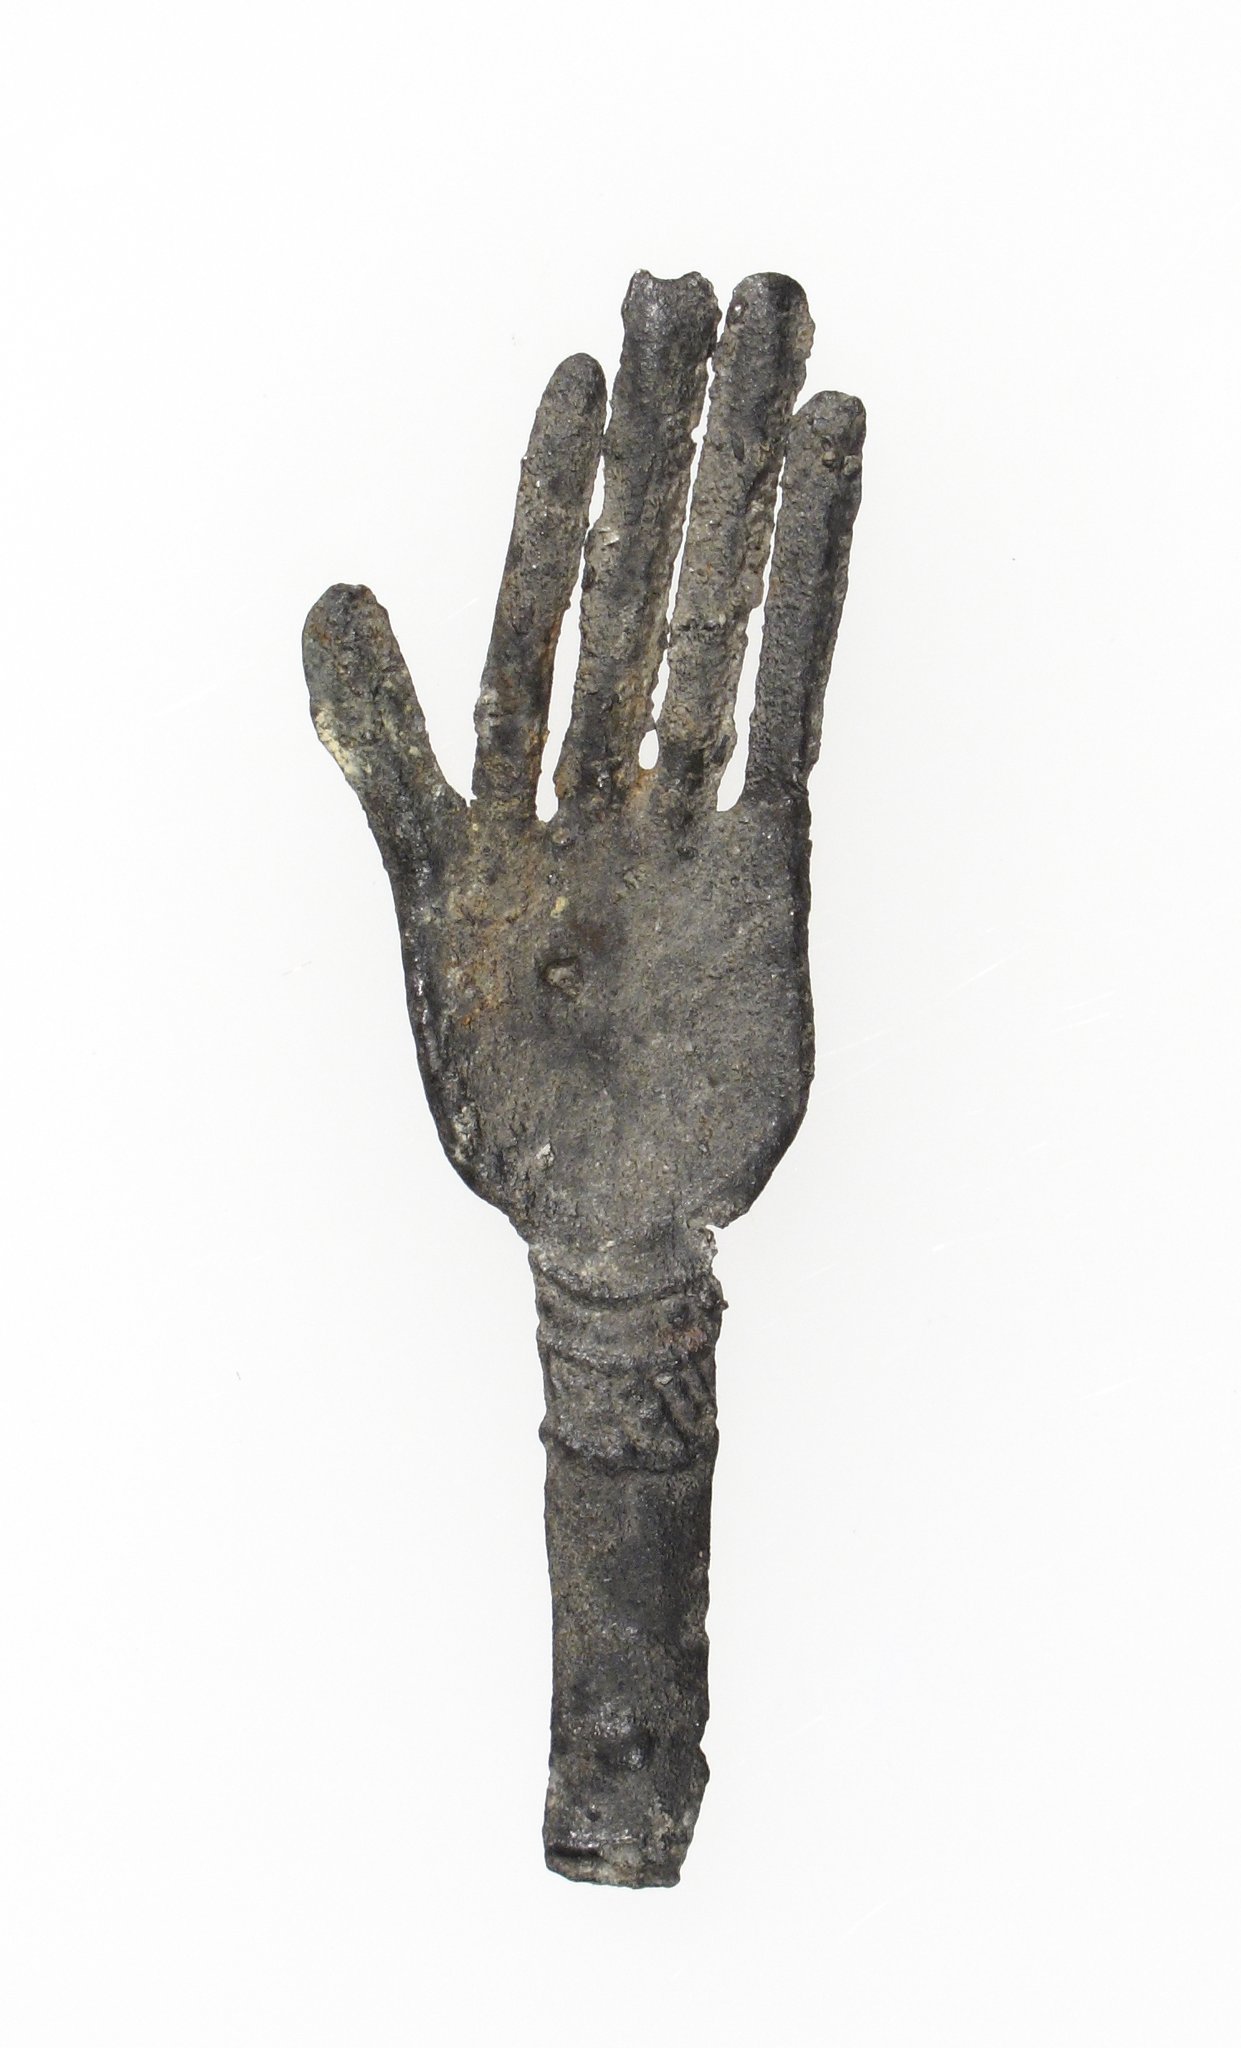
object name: pilgrim's badge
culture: french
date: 1301-1600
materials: lead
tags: hands